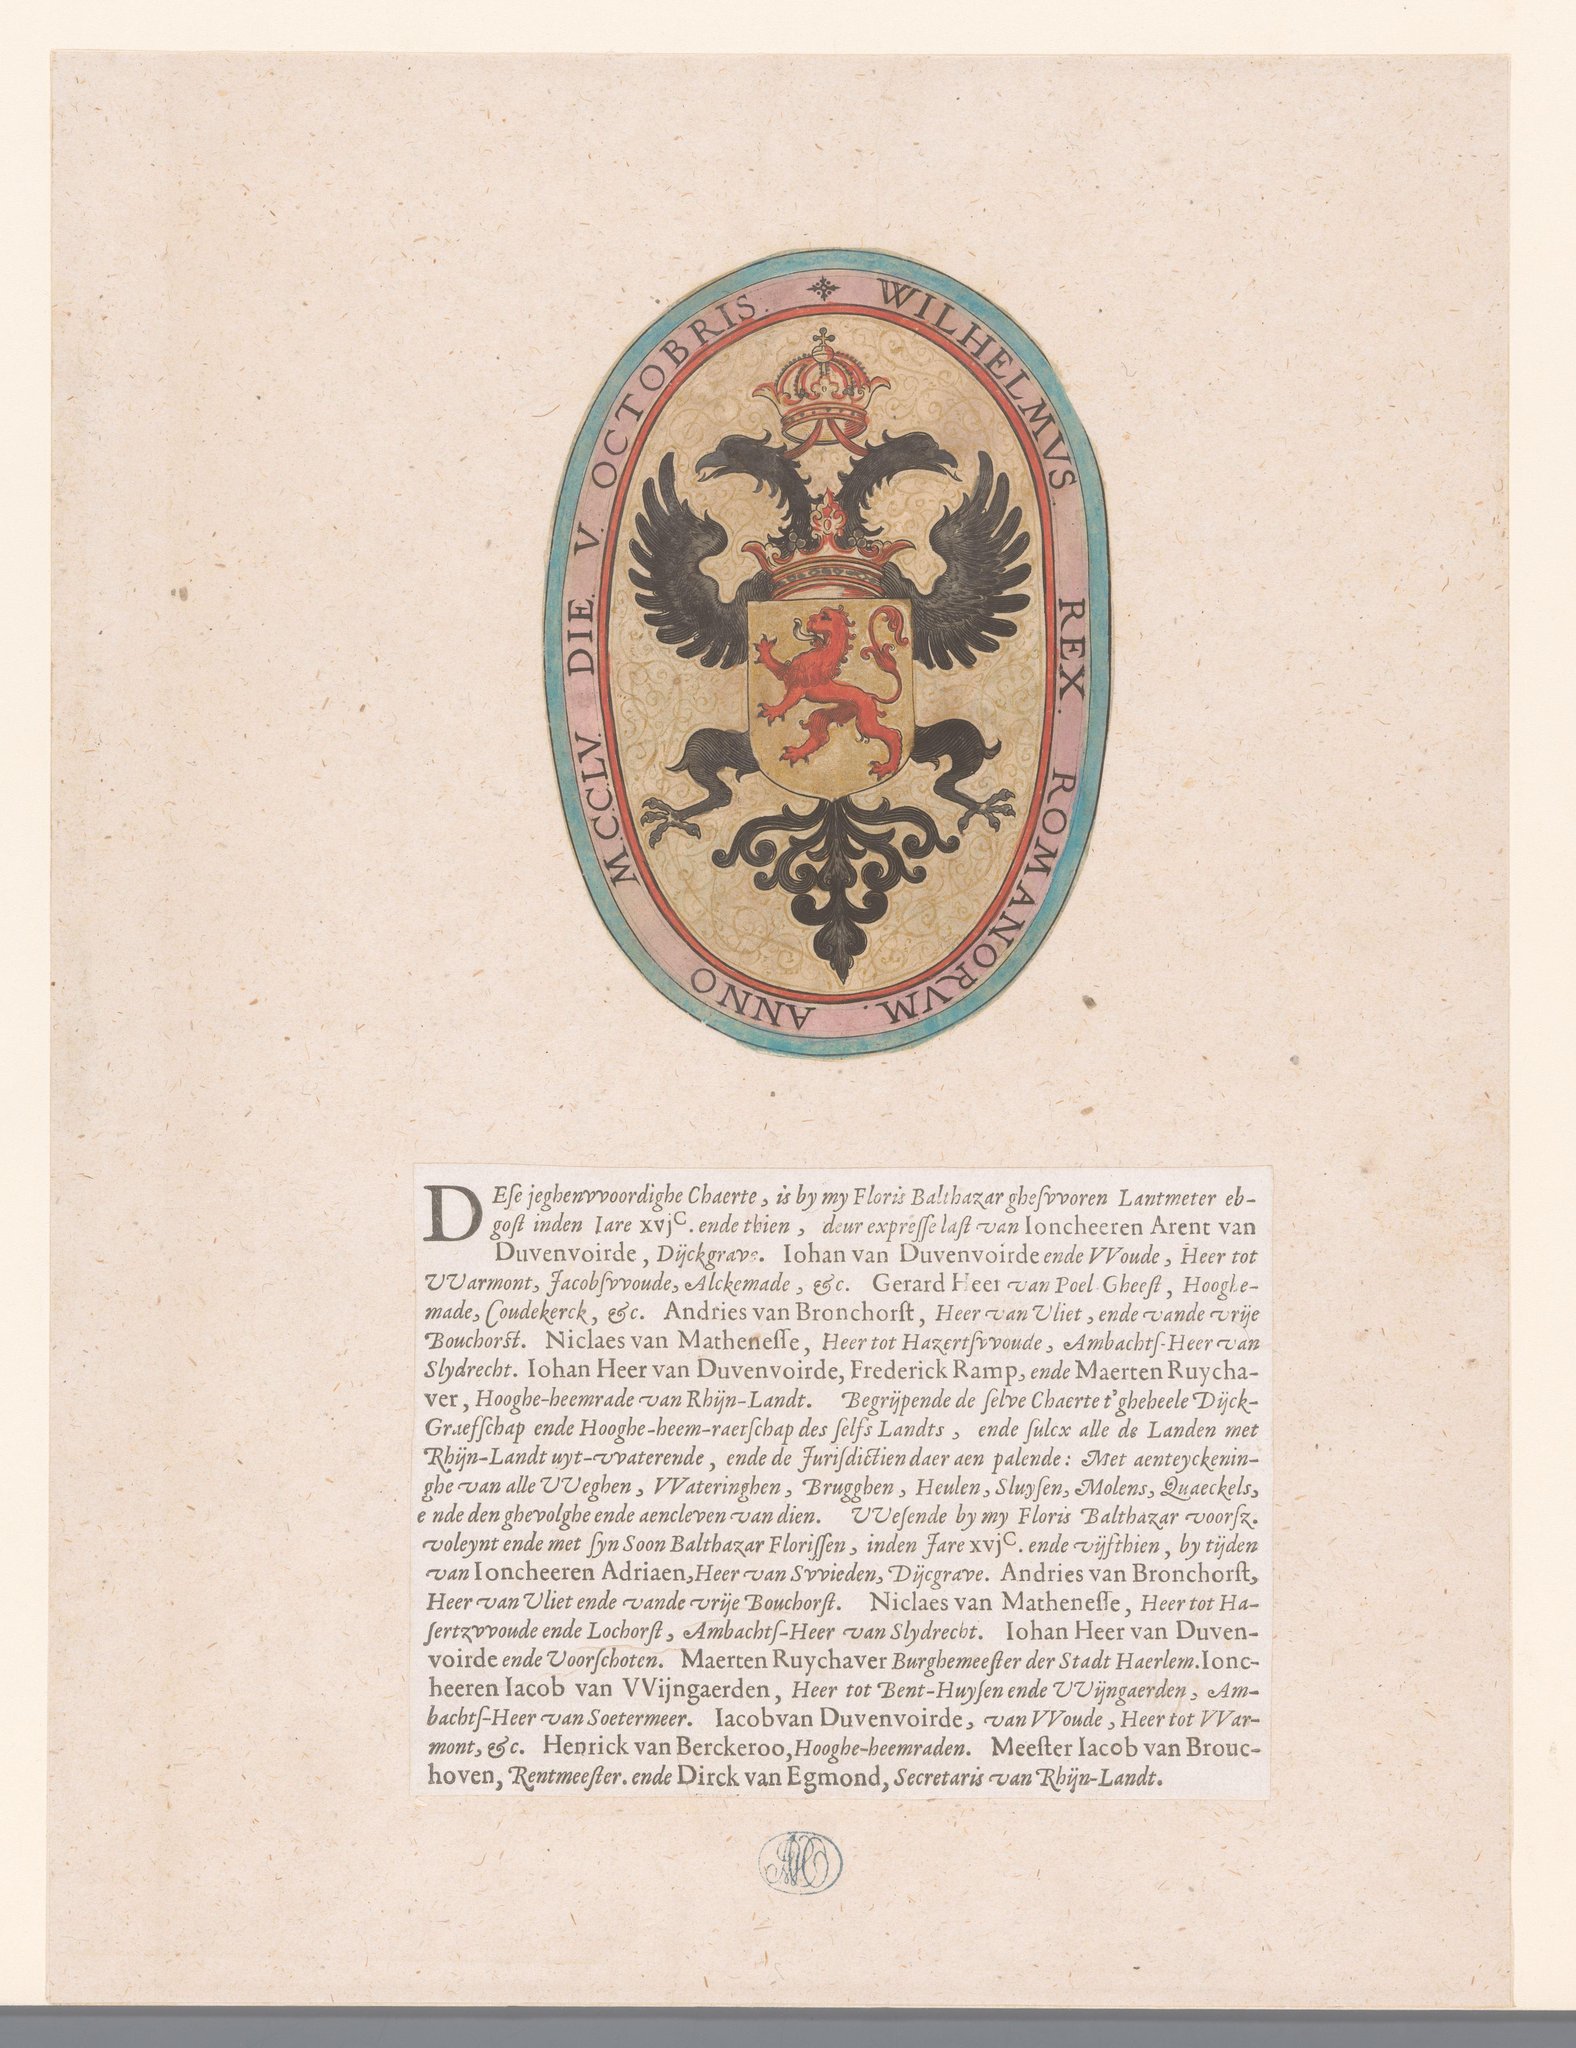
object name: print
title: Wilhelmus rex Romanorum anno MCCLV die V octobris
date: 1615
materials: paper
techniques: engraving, etching, hand coloring, letterpress printing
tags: armorial bearing, heraldry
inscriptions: collector's mark: Lugt 195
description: Wapenschild van graaf Willem II van Holland en tekst waarin de opdrachtgevers van Floris Balthasar van Berckenrode's kaart van het Hoogheemraadschap van Rijnland worden genoemd.